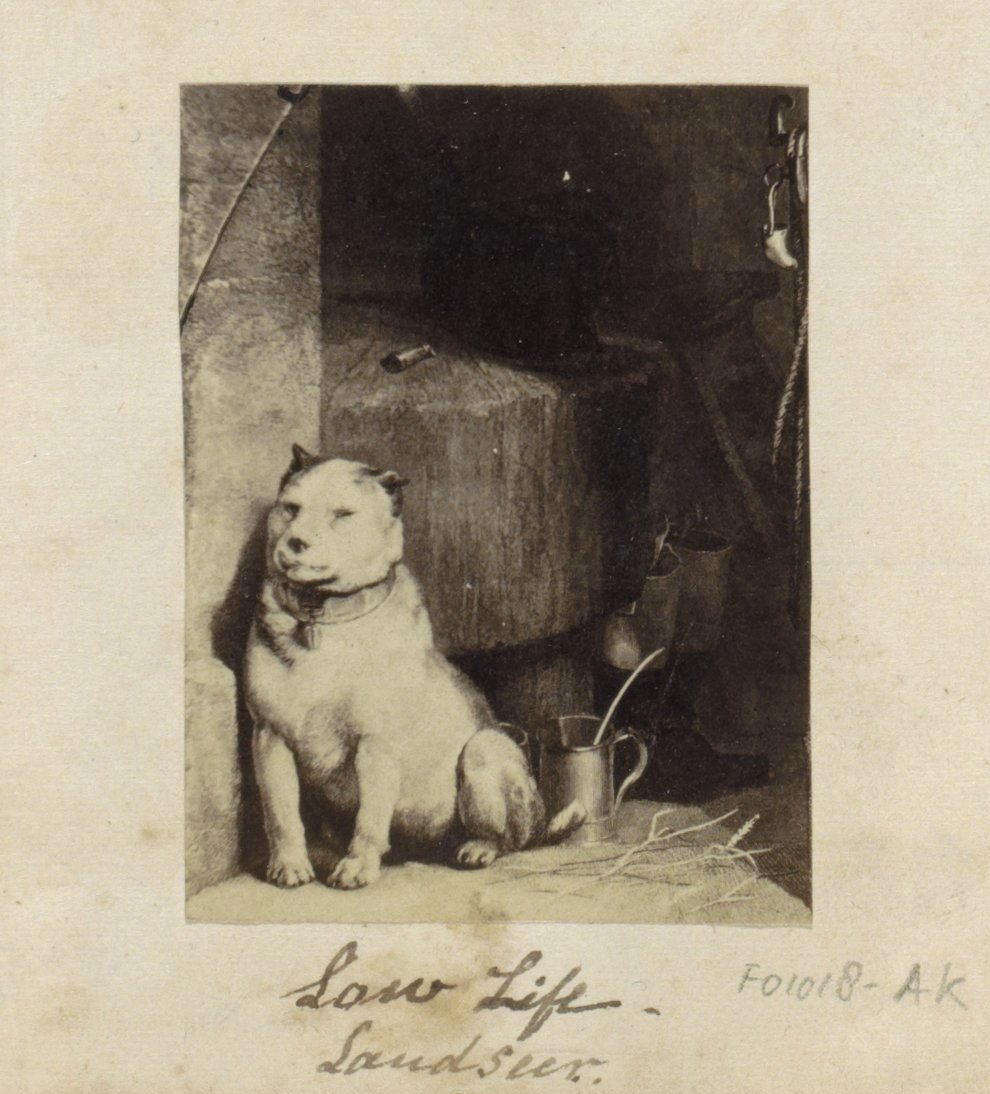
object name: reproduction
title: Fotoreproductie van een schilderij van Edwin Henry Landseer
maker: Anonymous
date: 1860-1870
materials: paper, photographic support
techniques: albumen print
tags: dog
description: Onderdeel van Engels familiealbum met foto's van personen, reizen, cricket en kunstwerken.